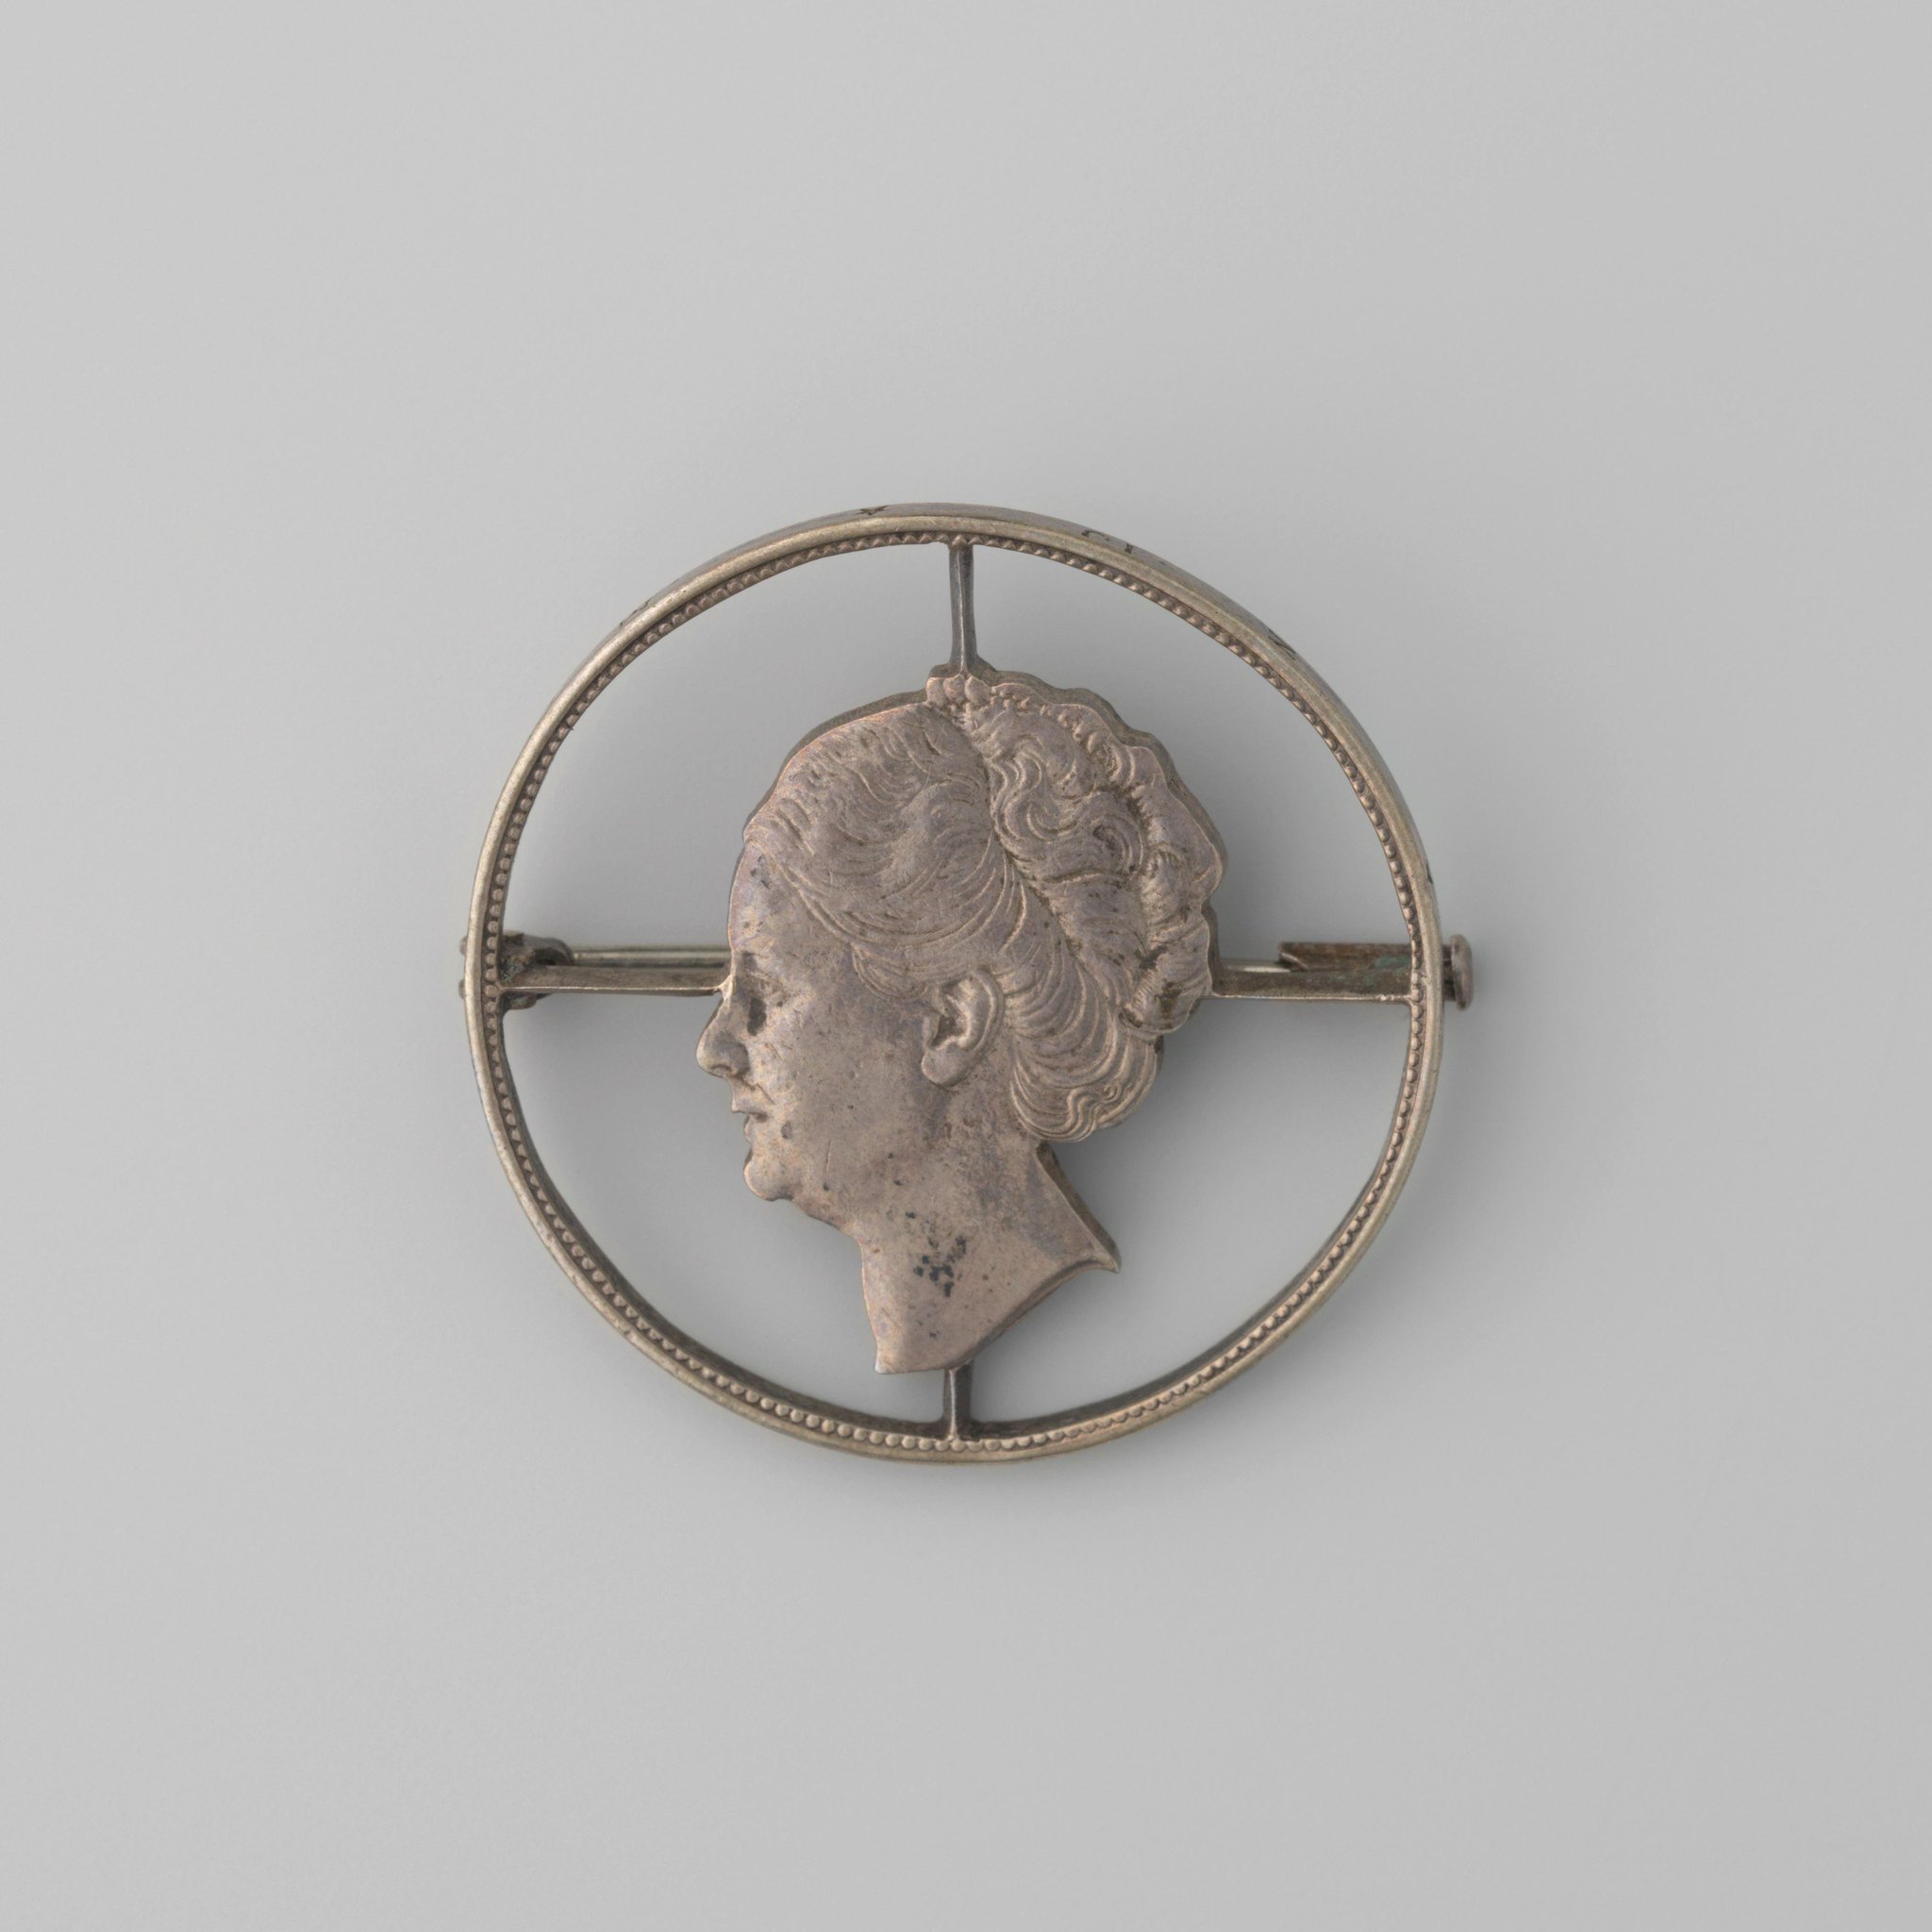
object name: brooch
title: Broche van zilveren munt met beeldenaar van Wilhelmina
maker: Anonymous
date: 1940-1950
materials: silver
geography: netherlands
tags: print maker, wilhelmina of the netherlands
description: Broche van zilveren munt met beeldenaar van Wilhelmina, voorzien van een kanonsluiting. Het portret is uitgezaagd.